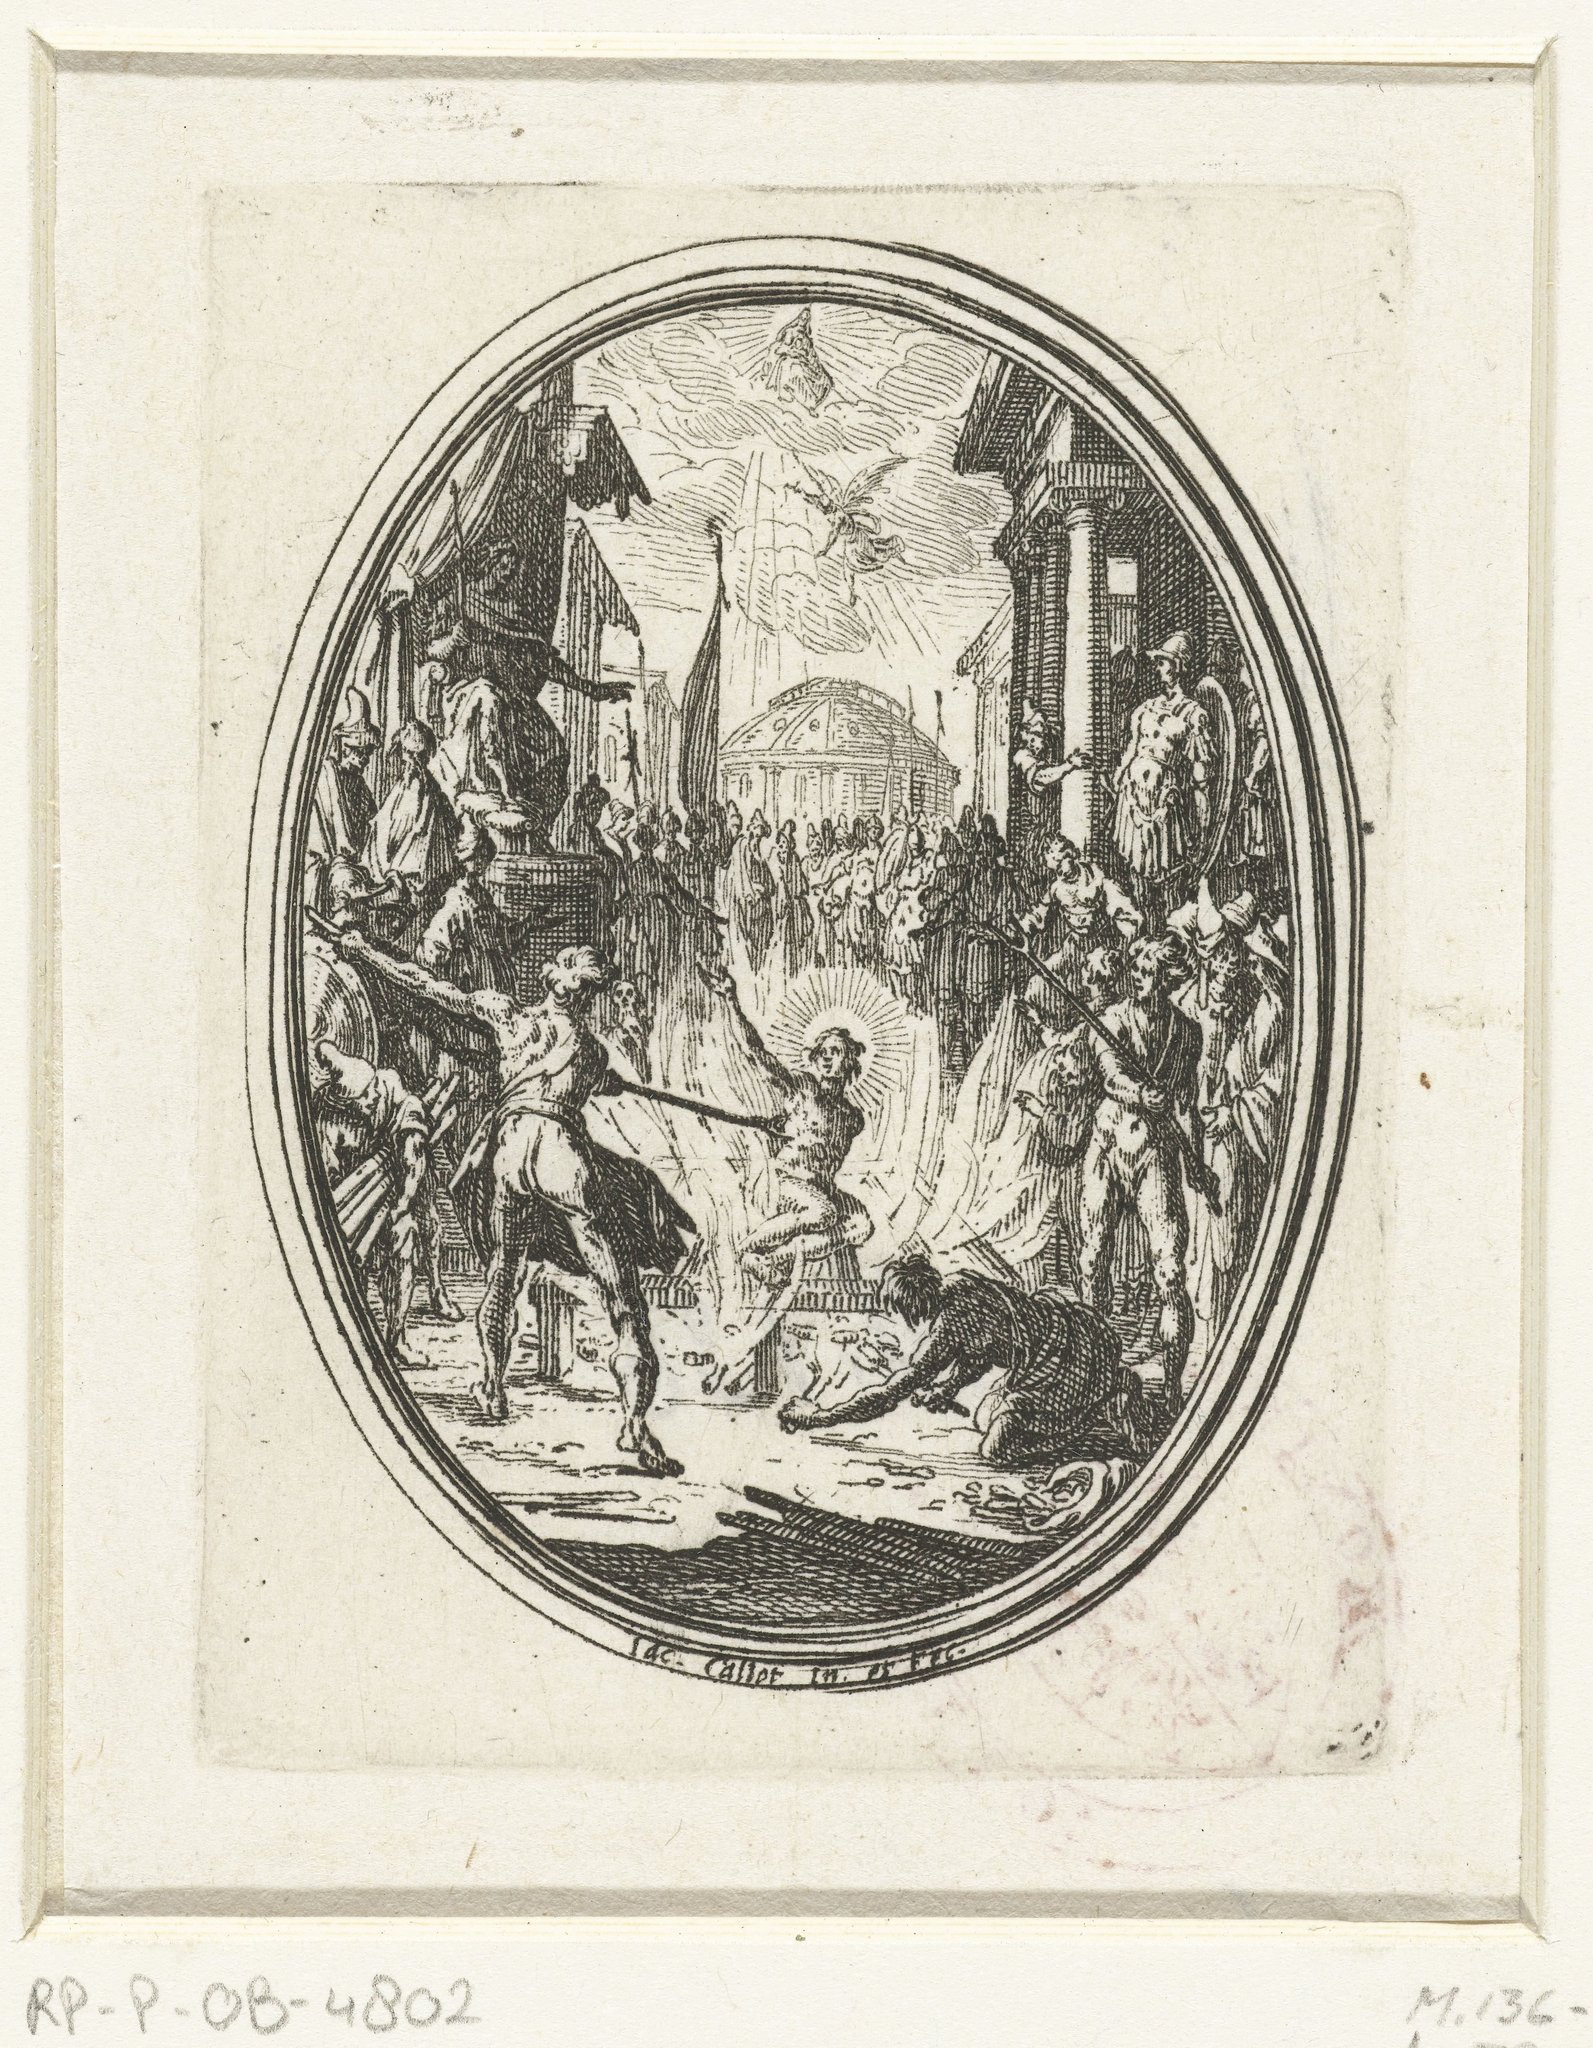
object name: print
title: Het martelaarschap van de Heilige Laurentius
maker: jacques callot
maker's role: draughtsman, print maker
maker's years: 1592-1635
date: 1626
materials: paper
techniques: etching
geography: nancy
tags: st. laurence is roasted on a gridiron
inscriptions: collector's mark: Lugt 240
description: Ovale voorstelling van de Heilige Laurentius die wordt geroosterd. Zijn beulen stoken het vuur op en houden Laurentius met spiesen in bedwang. Links op de achtergrond kijkt een Romeinse prefect toe vanaf zijn troon.